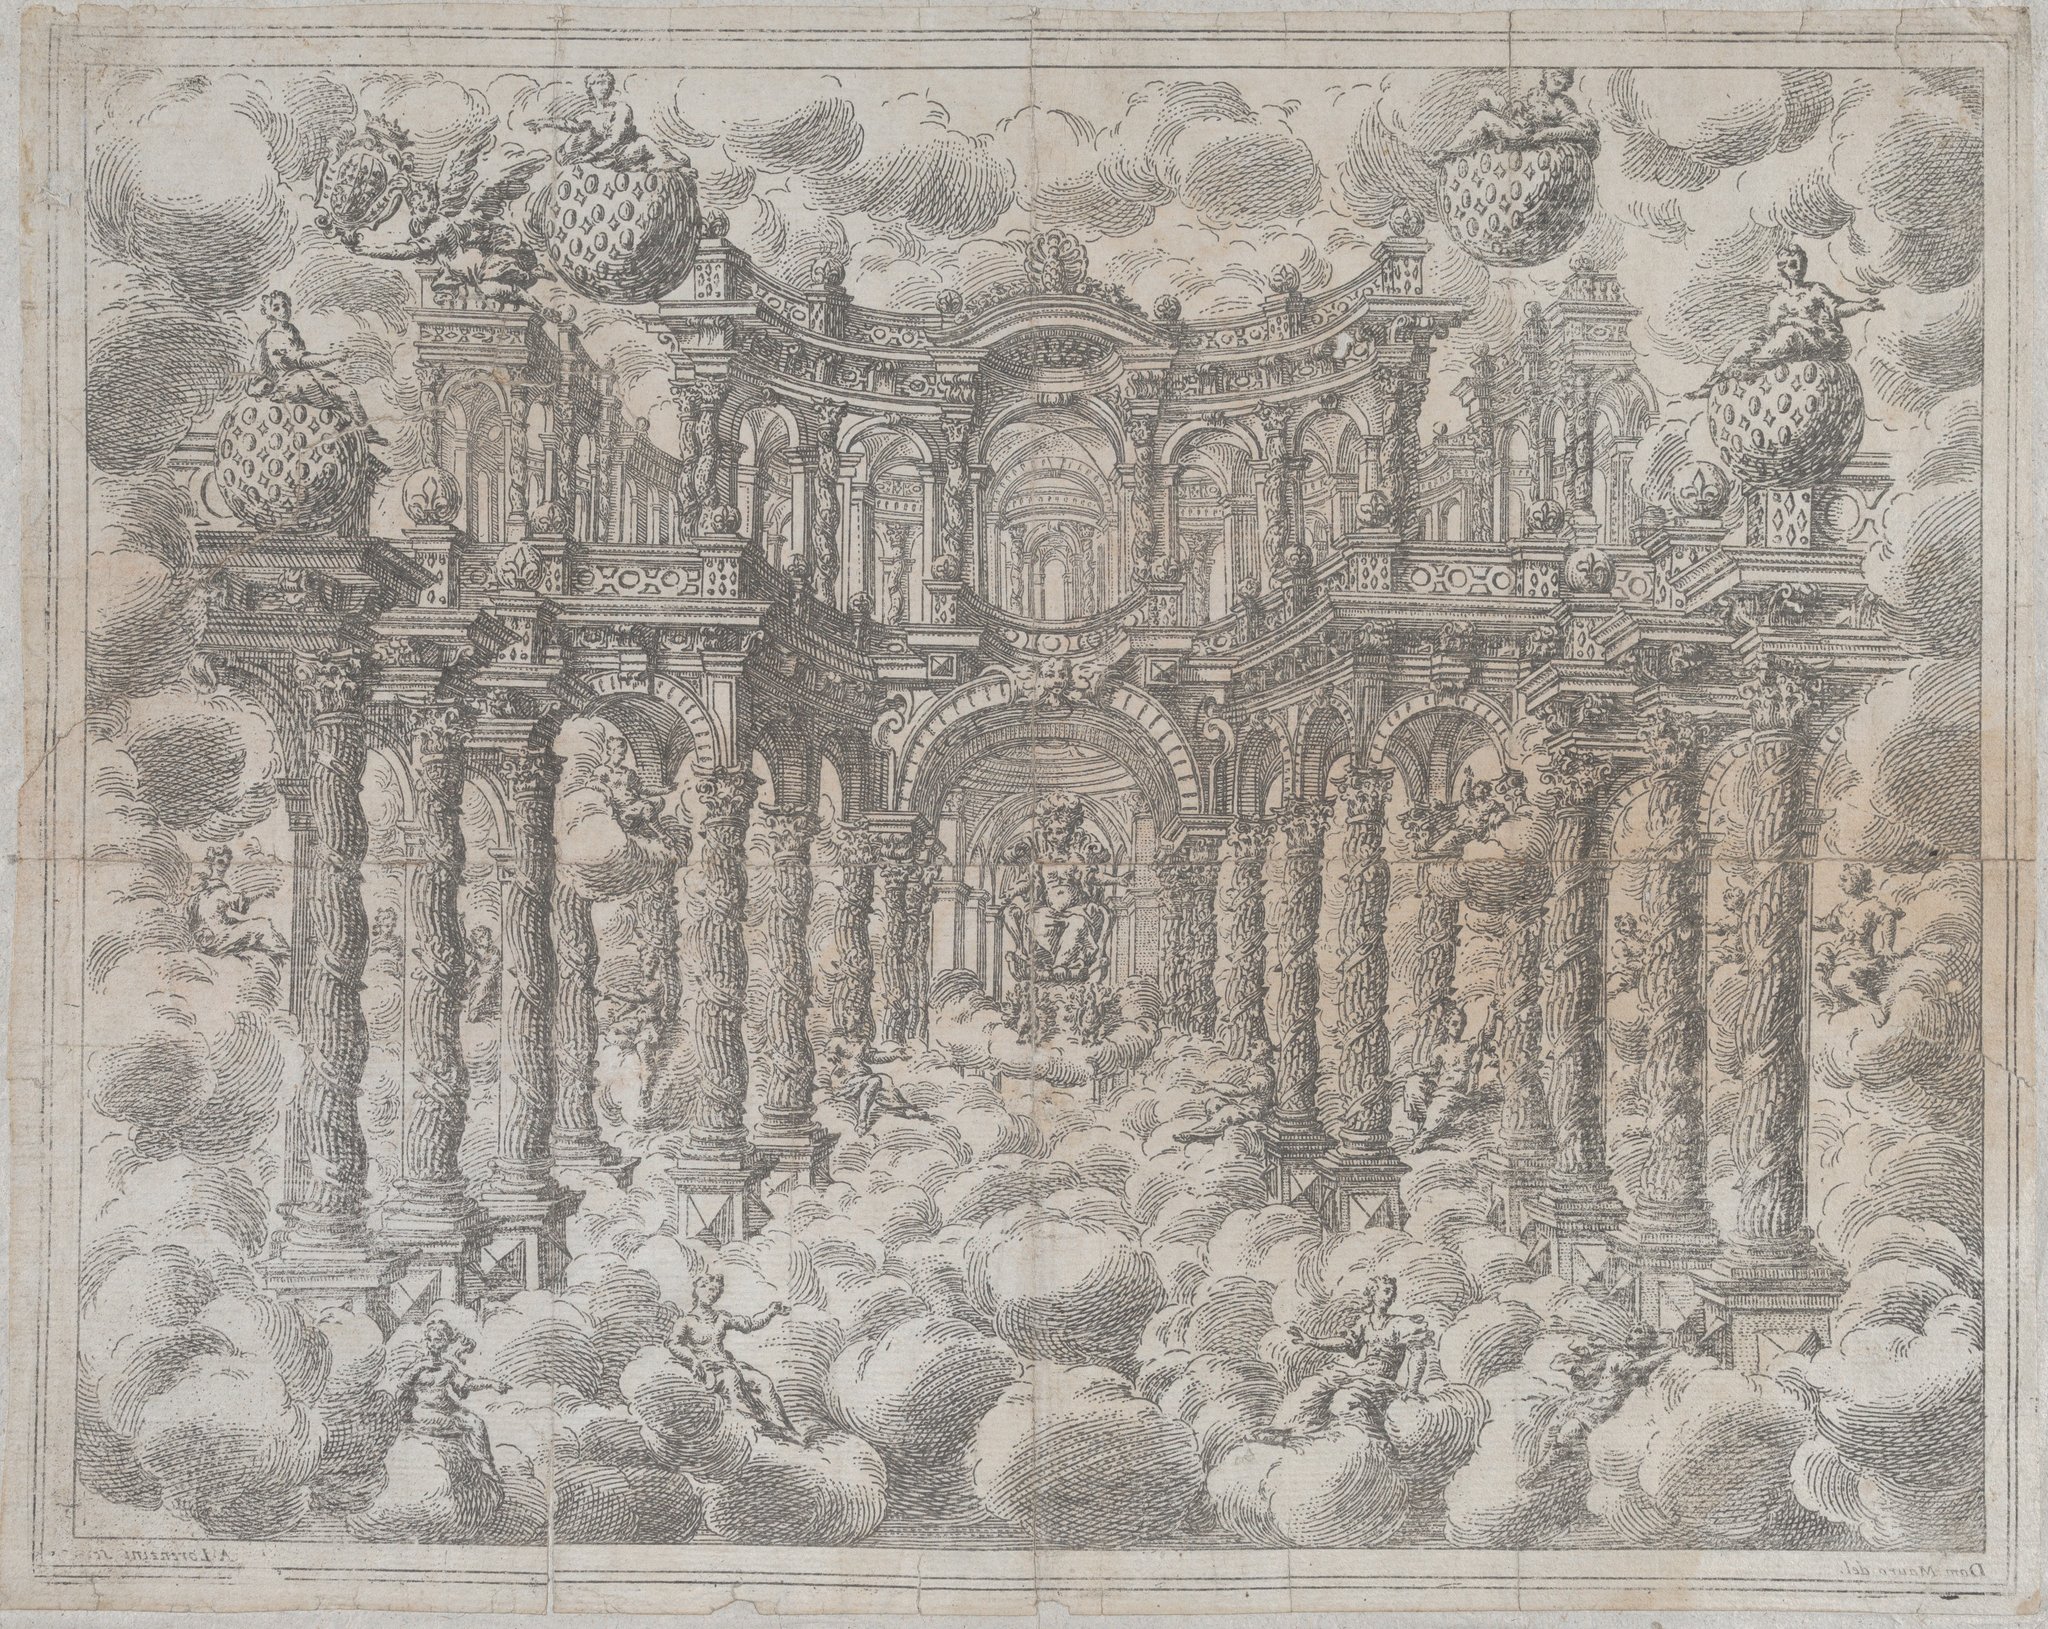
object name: print, fete, ornament architecture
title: Plate 2 [counterproof]; stage set with allegorical figures seated among the clouds, with a large colonnade in the background; from Aurelio Aureli's "Il Favore De Gli Dei"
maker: gianantonio lorenzini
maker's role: artist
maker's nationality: italian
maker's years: 1665-1740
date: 1690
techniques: etching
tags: columns,clouds,stage design